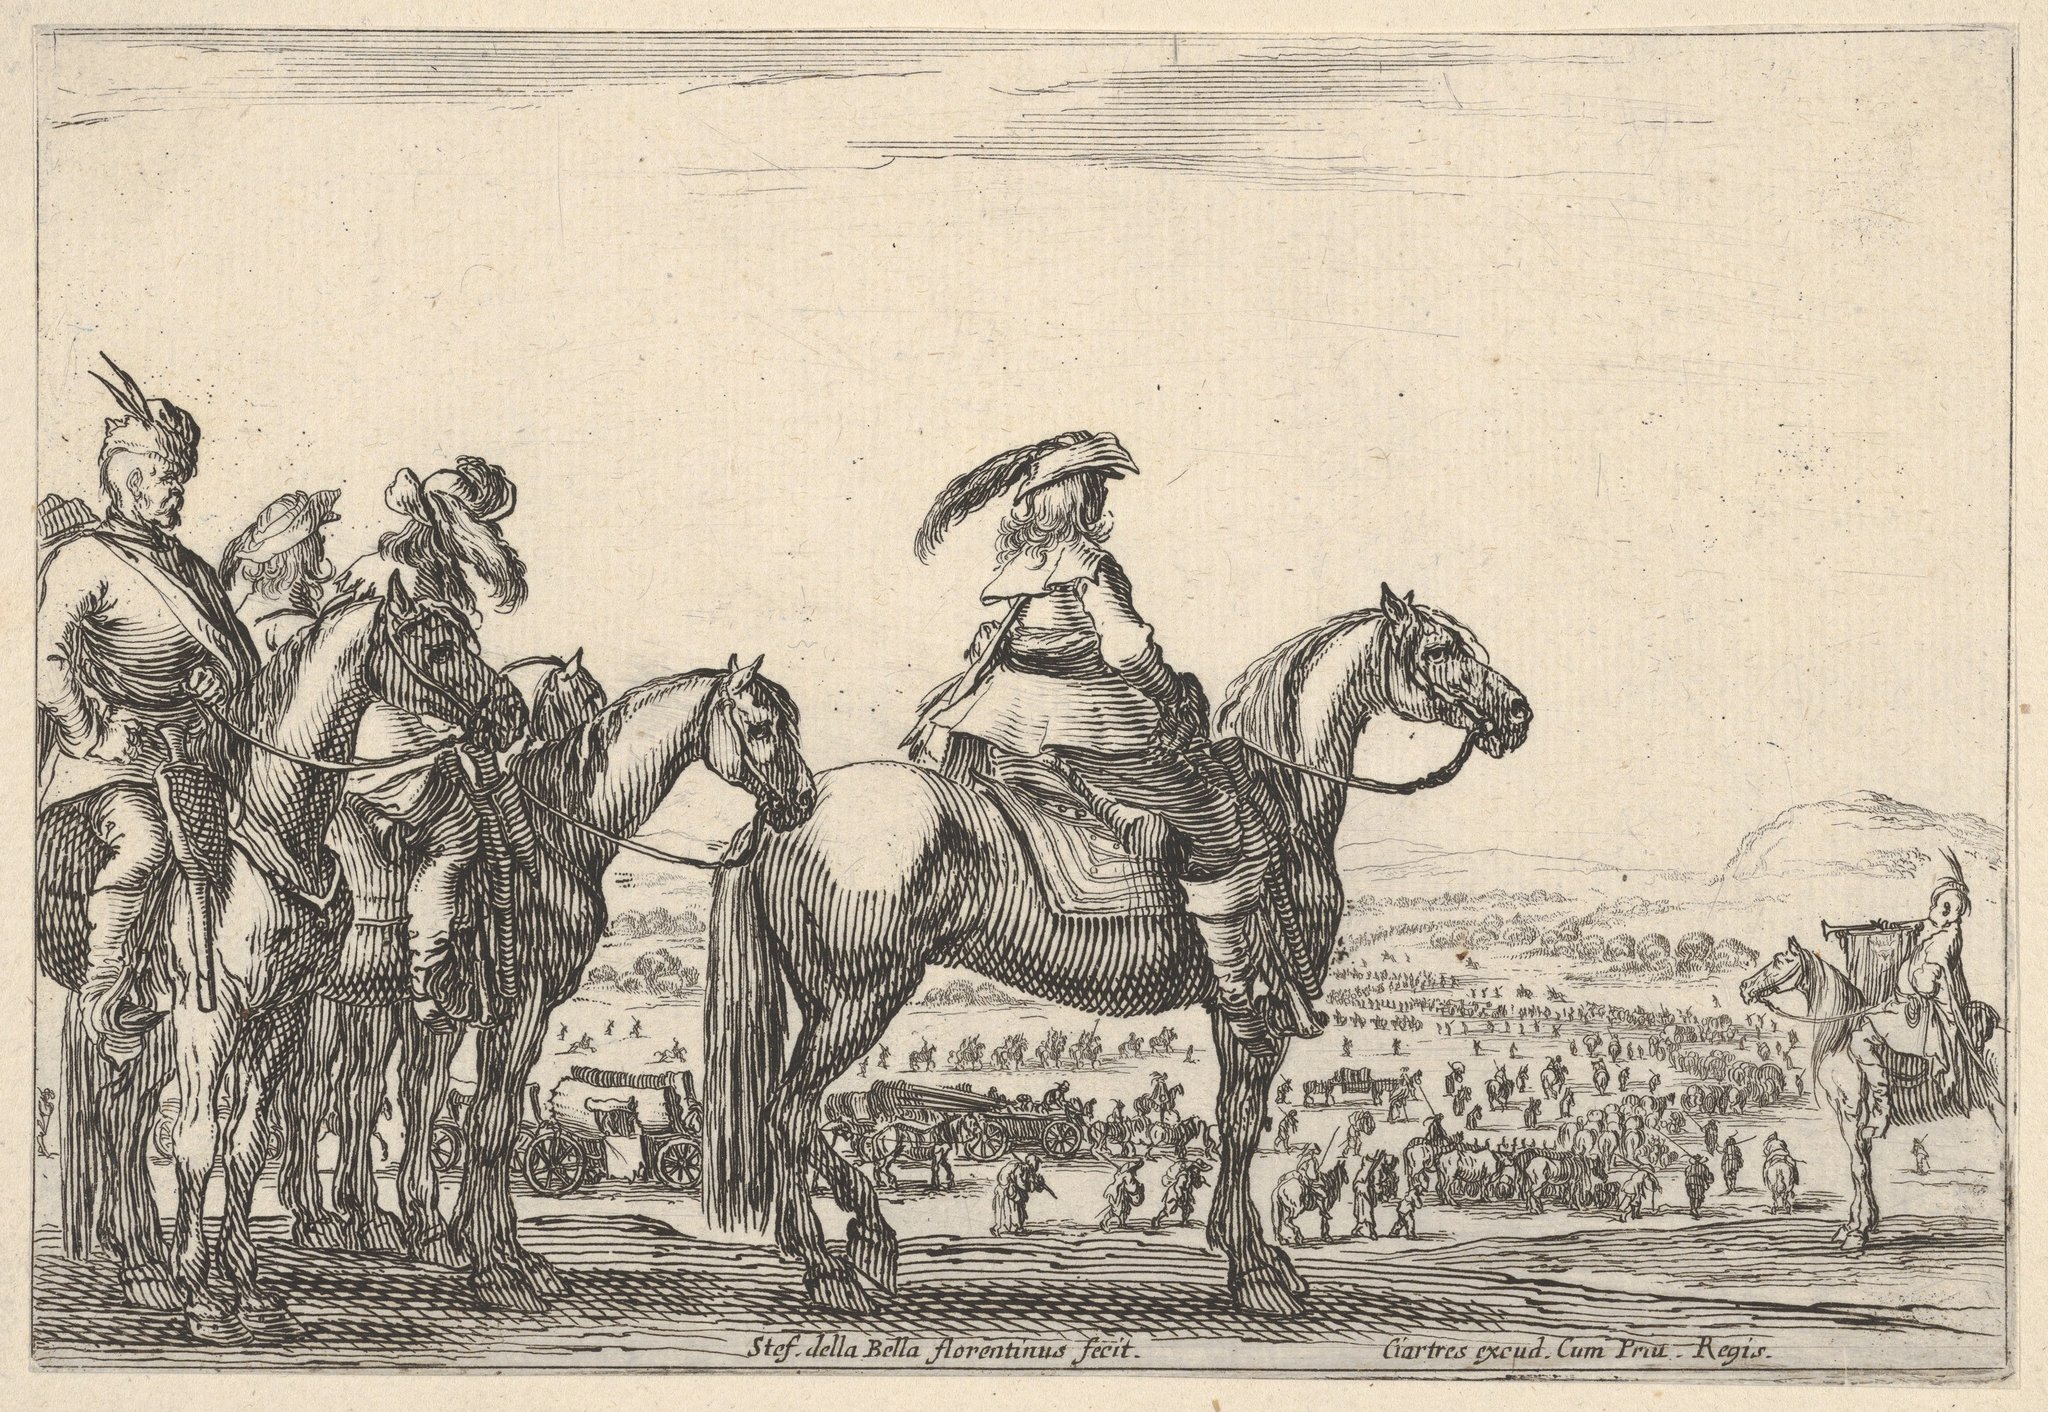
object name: print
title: March of an army on a plain, the commander in chief in front, his aides behind him, a trumpeter on horseback at right, a plain with various figures and horses in the background, from "Varie Figure"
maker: stefano della bella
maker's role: artist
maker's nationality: italian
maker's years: 1610-1664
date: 1645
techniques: etching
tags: army,soldiers,men,trumpets,horses